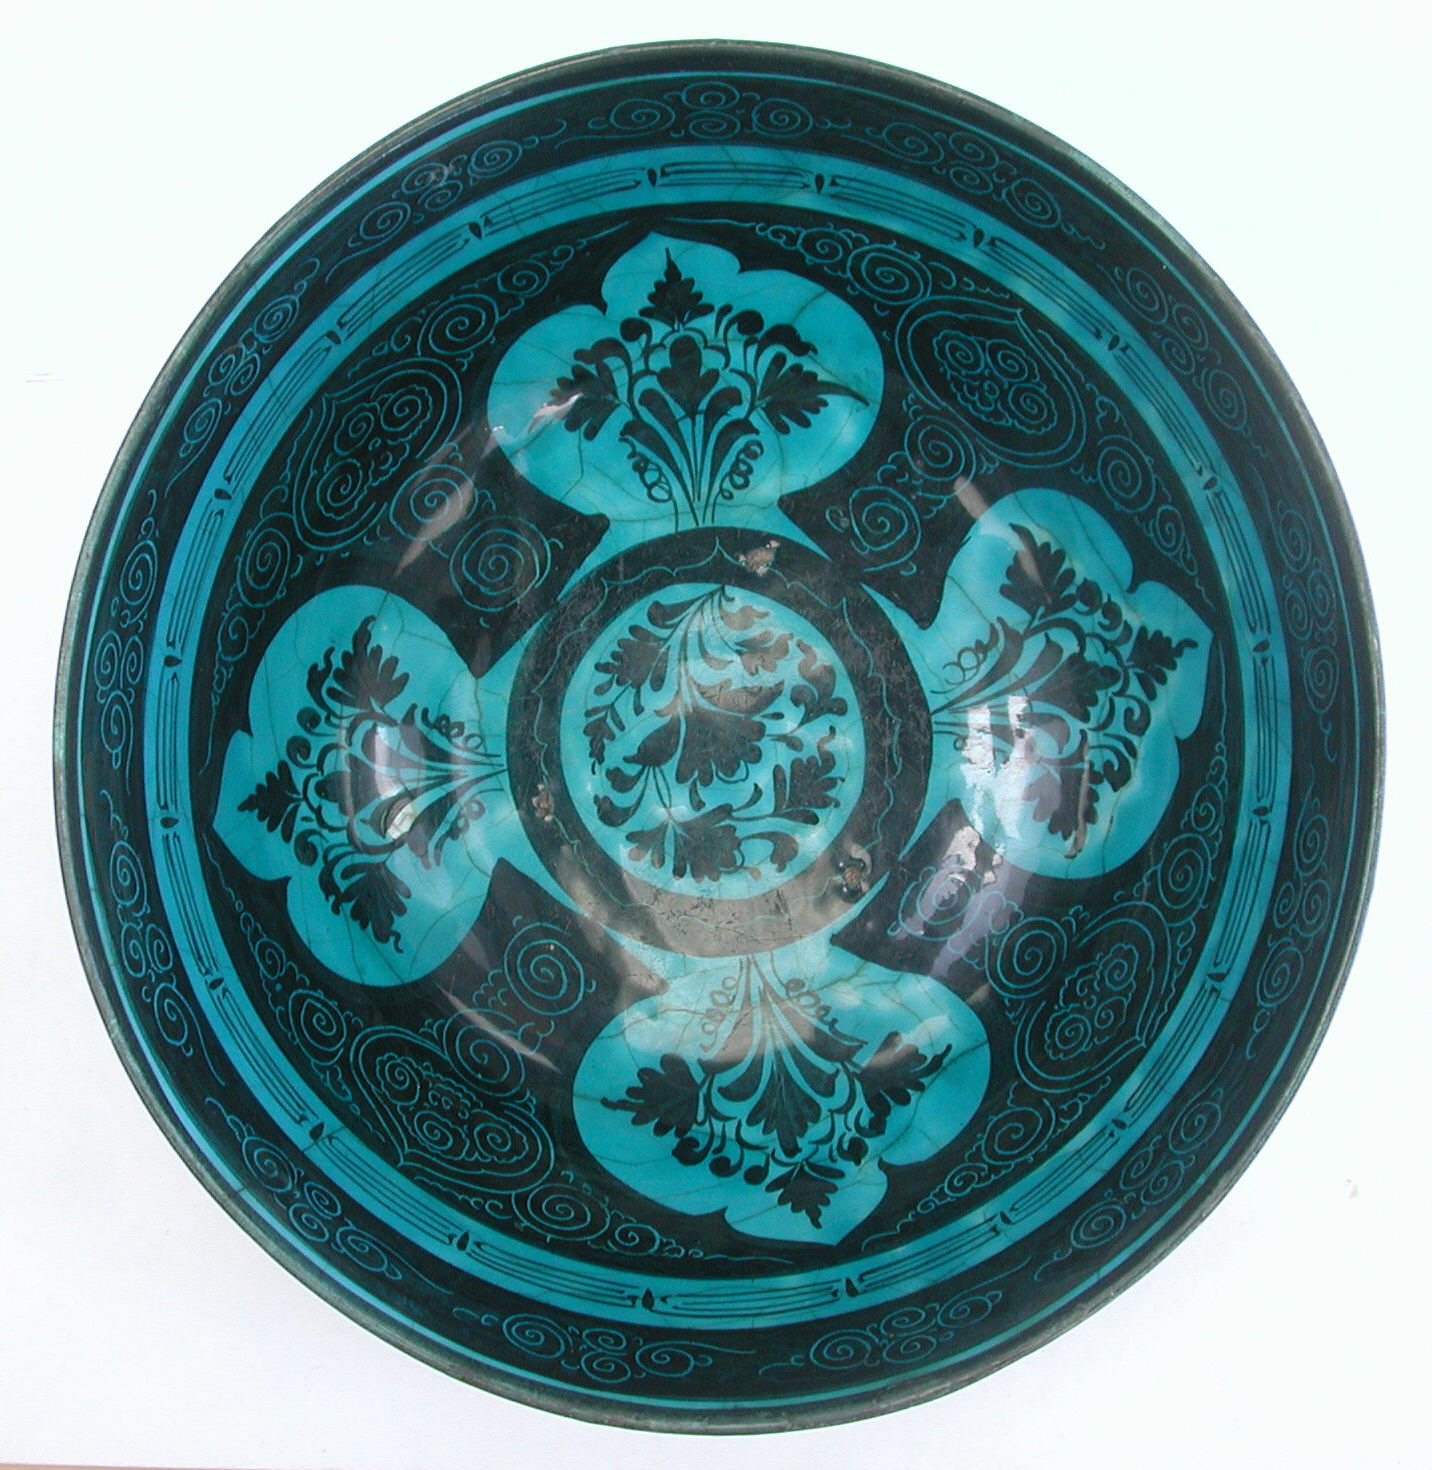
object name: bowl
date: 1451-1500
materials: glaze, stonepaste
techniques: incising, painting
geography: iran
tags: flowers